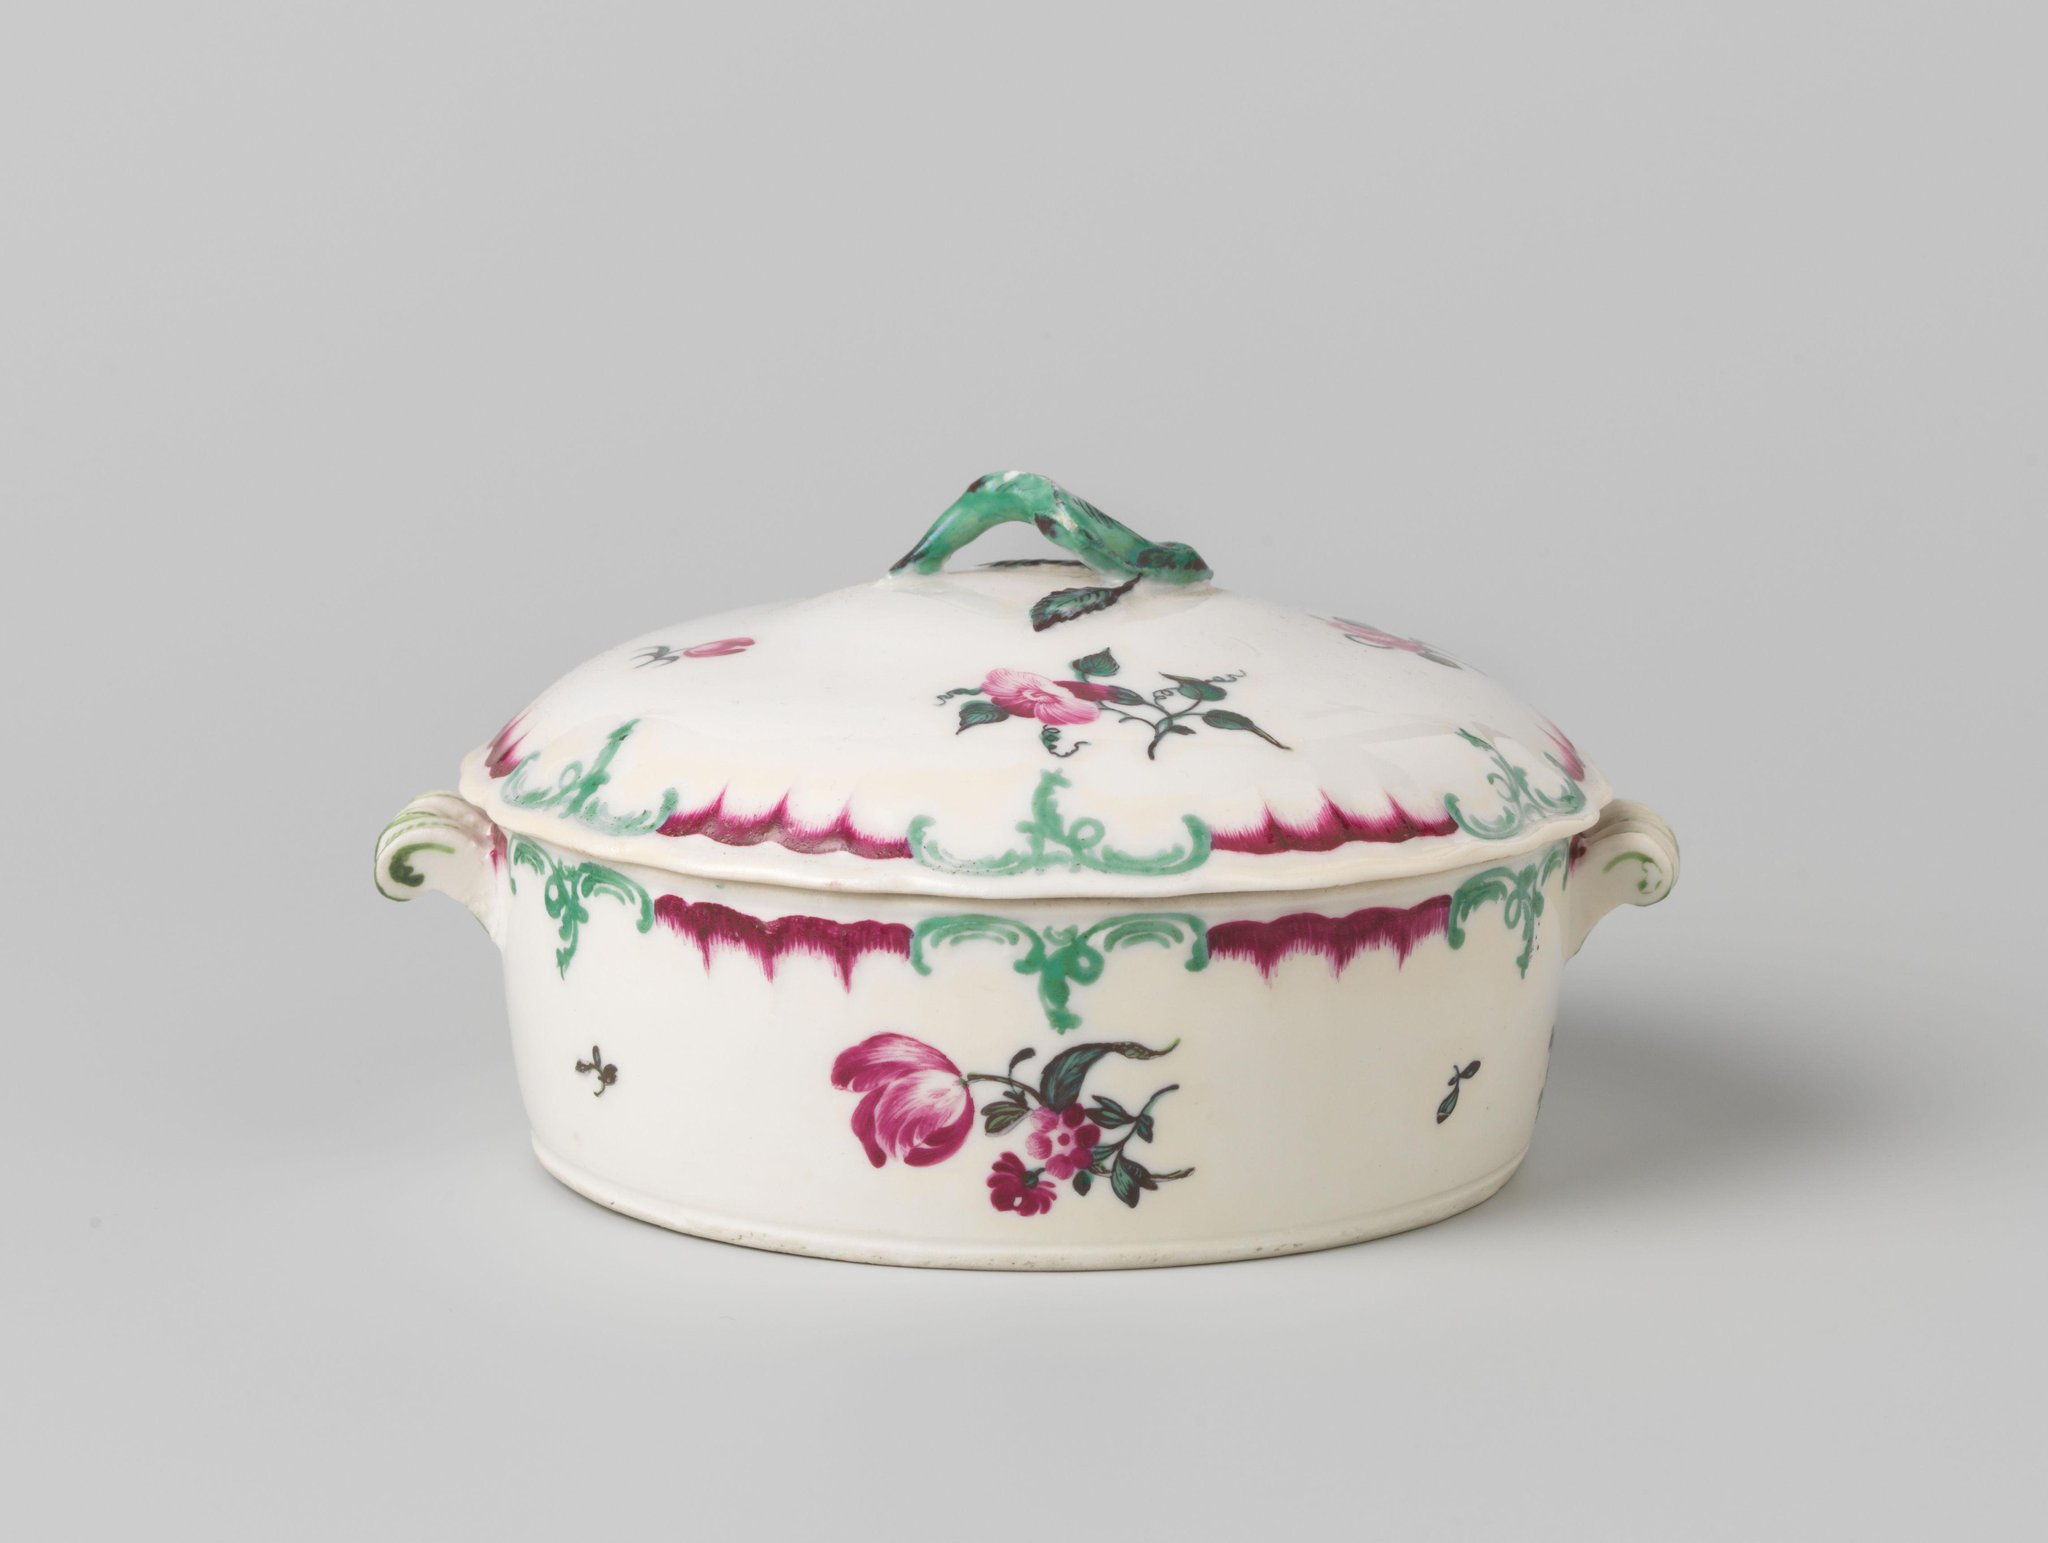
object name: butter dish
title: Botervloot, beschilderd met bloemtakjes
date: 1778-1782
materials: porcelain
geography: loosdrecht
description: Botervloot van porselein. Rond, met twee oortjes. Langs de randen van botervloot en deksel rocailleornamenten in reliëf en beschilderd in bietenrood en lichtgroen. Wand en deksel beschilderd met bloemtakjes in bietenrood en twee kleuren groen, de oortjes in groen.